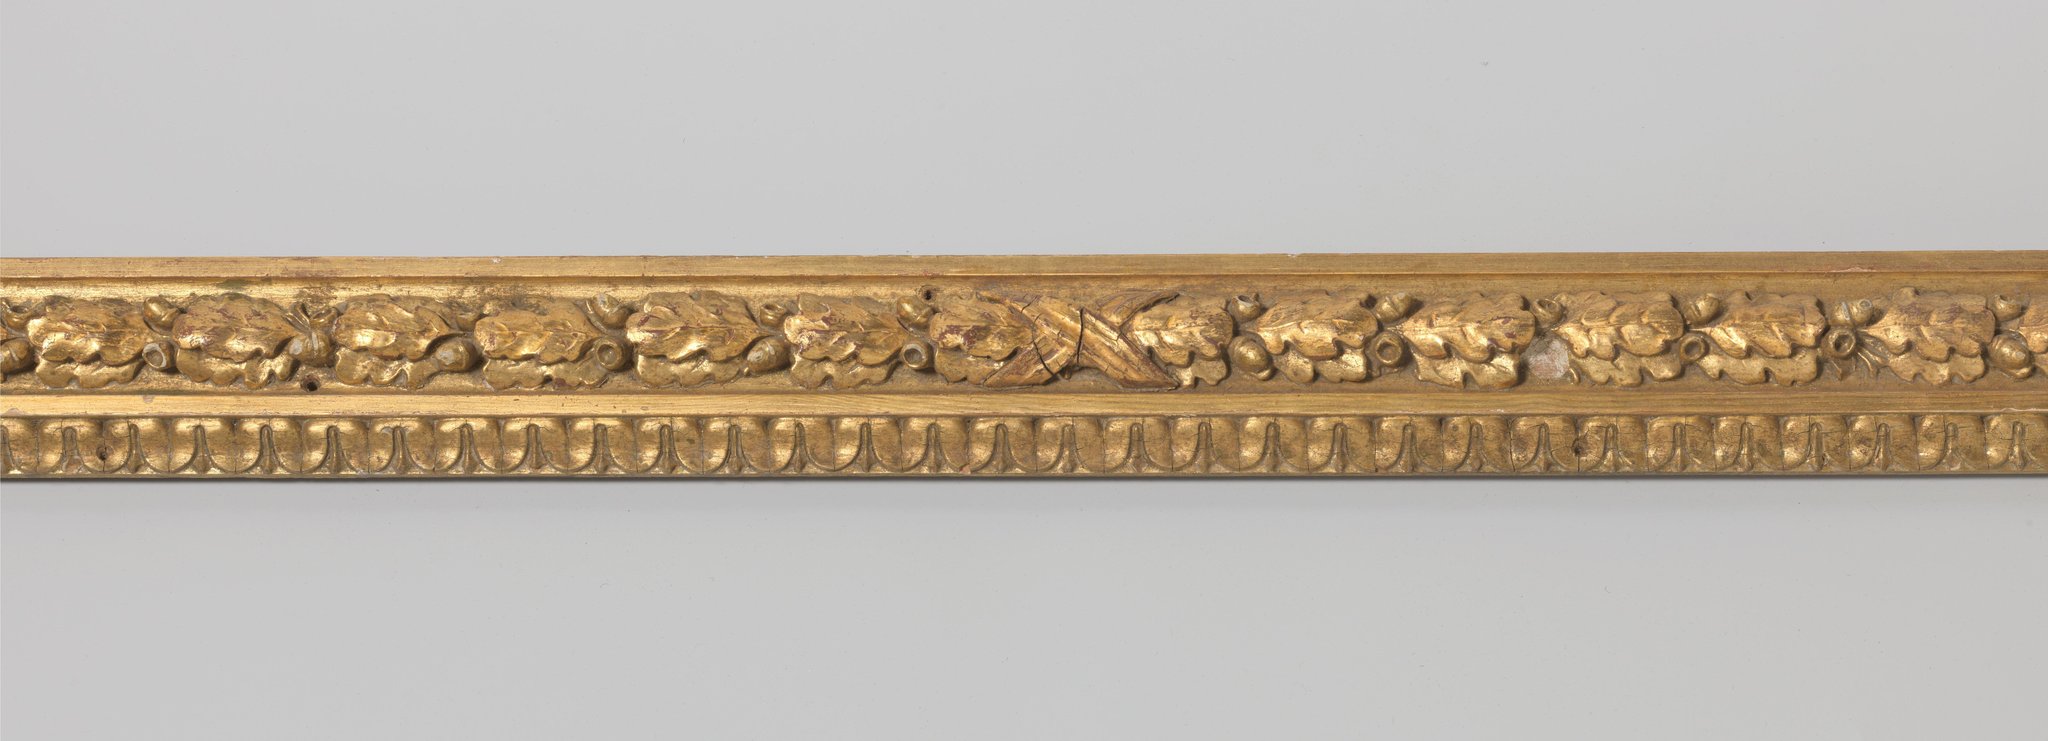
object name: frame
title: Lijstfragment: vergulde lijst met pâte-ornamenten, bovenregel.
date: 1700-1899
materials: gold leaf, wood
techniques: gilding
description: Vergulde lijst met eikenbladeren met eikeltjes. Lijstdeel, boven regel. Met achterop geschreven: 'Top, Panel right of door, no. 1'.